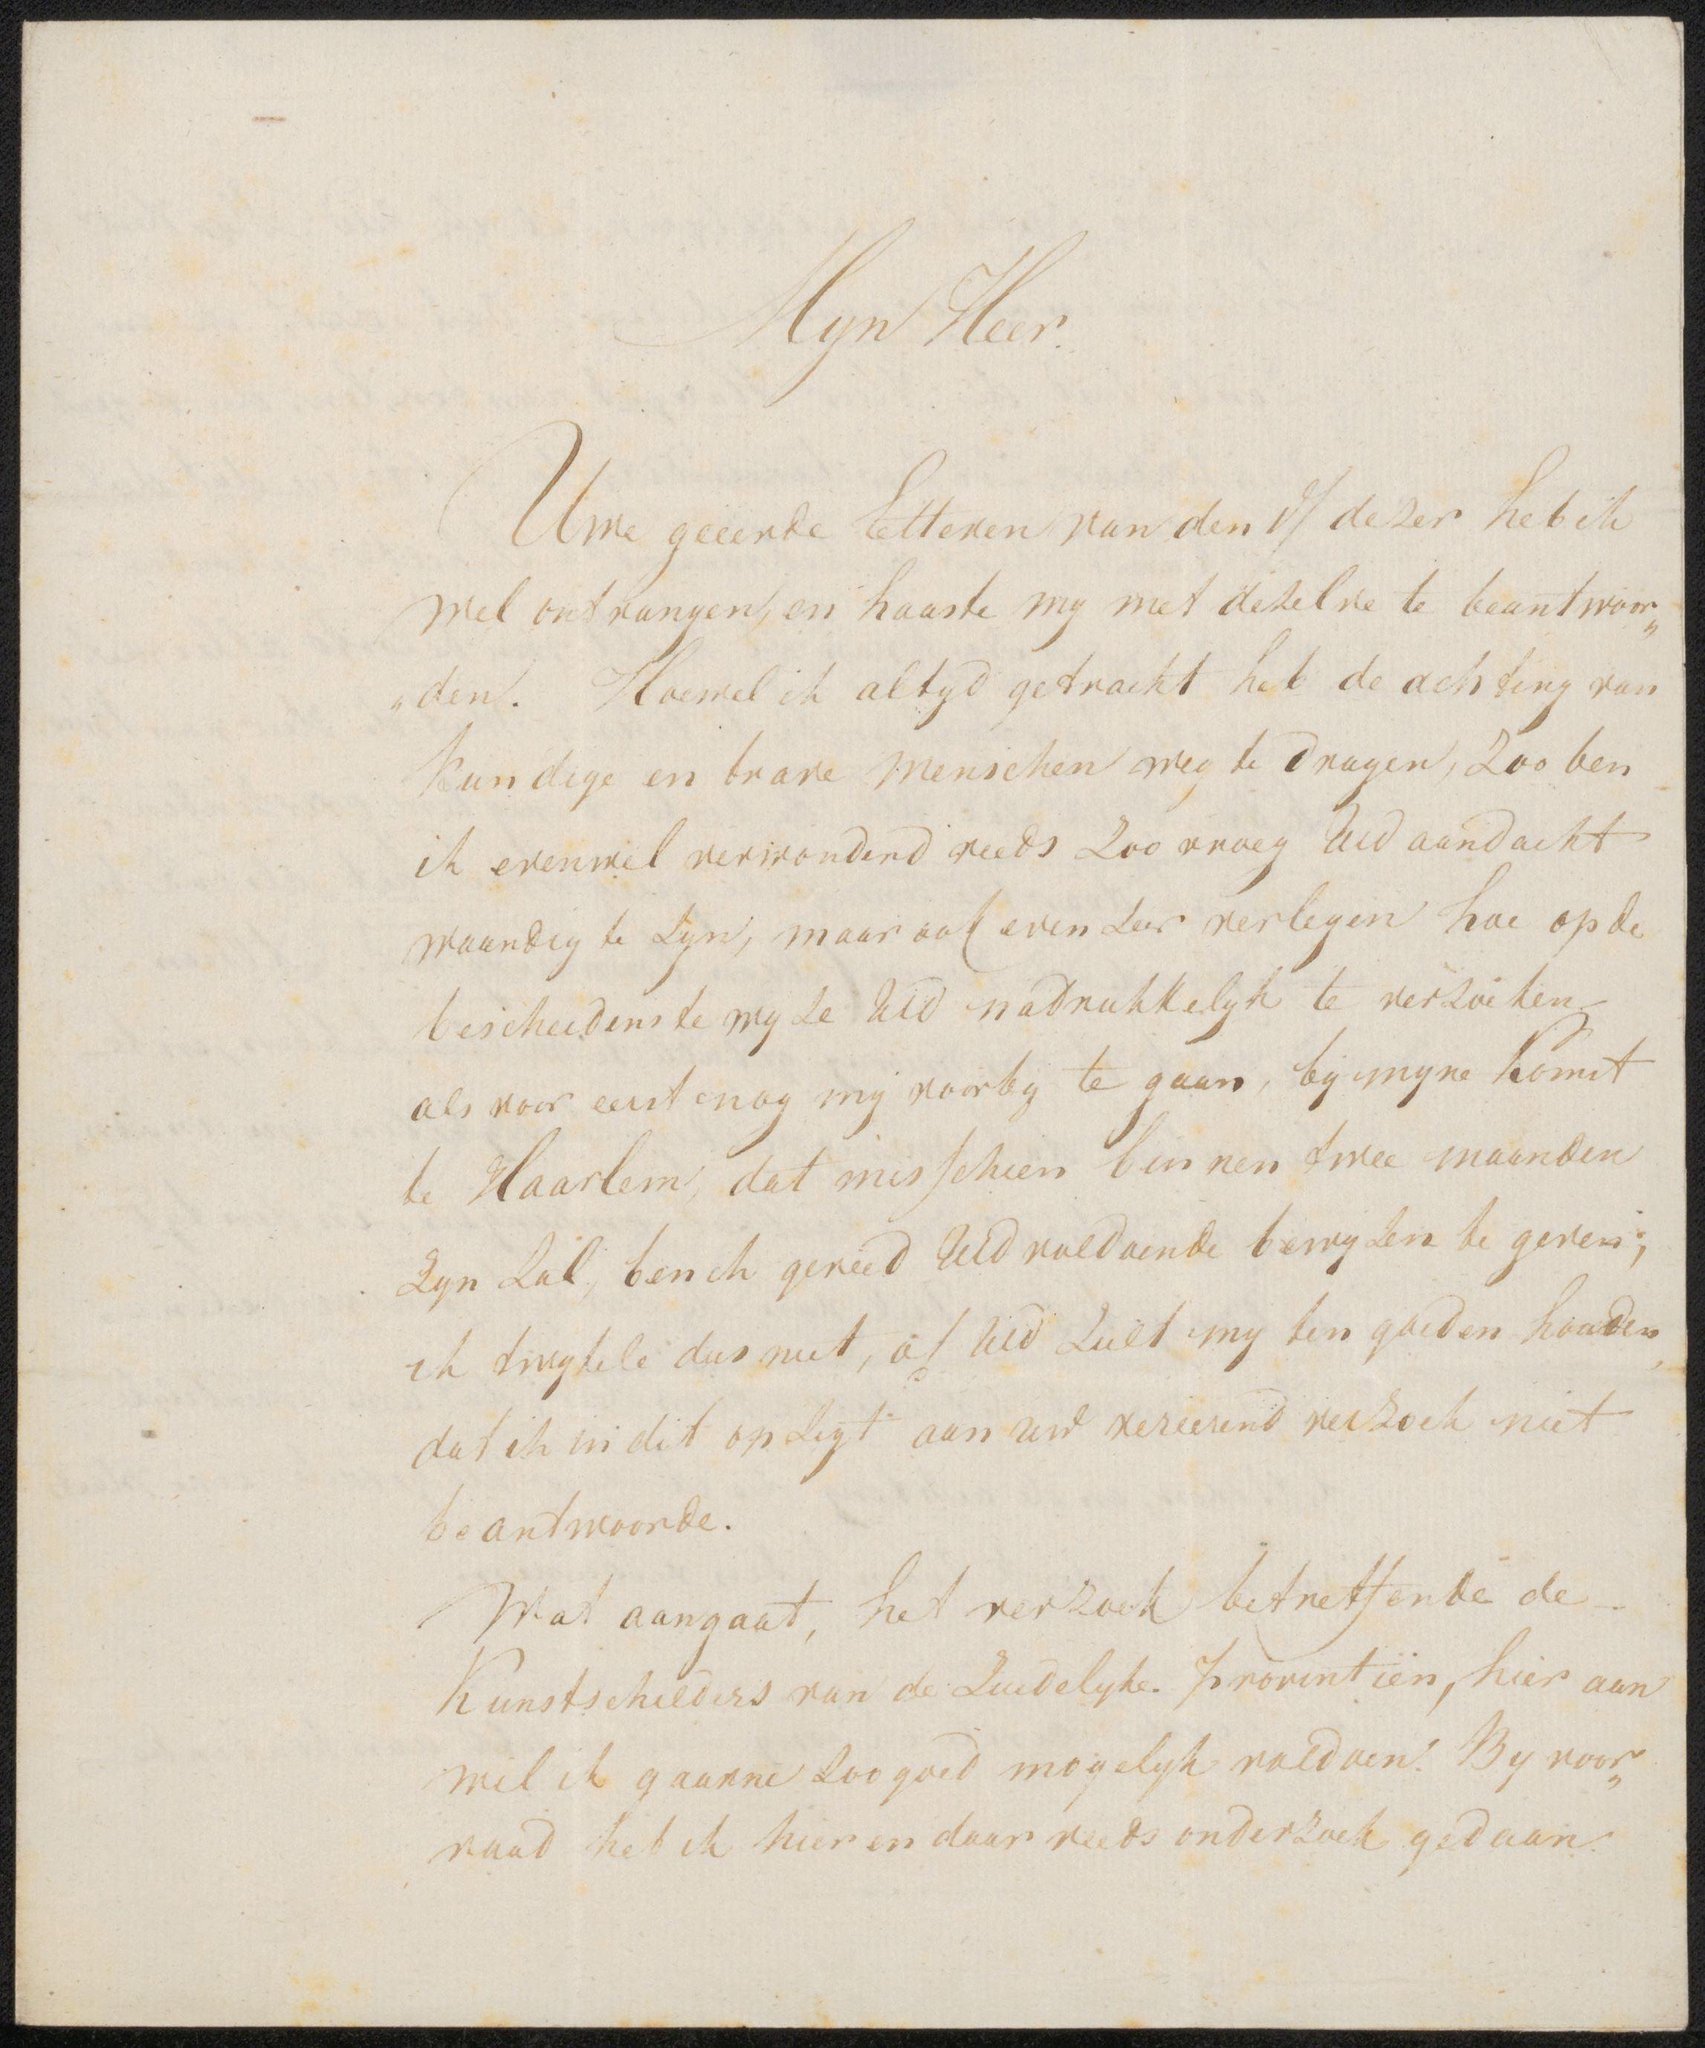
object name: letter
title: Brief aan Adriaan van der Willigen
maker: jacobus schoemaker doyer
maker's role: draughtsman, painter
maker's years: 1792-1867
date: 1816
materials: ink, paper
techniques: pen, writing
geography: antwerp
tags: antwerp, draughtsman, willem jacob herreyns, mattheus ignatius van bree, painter, print maker, balthasar paul ommeganck, brussels, cornelis cels, rotterdam, adriaan van der willigen, painting (including book-illumination, miniature-painting)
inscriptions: watermark